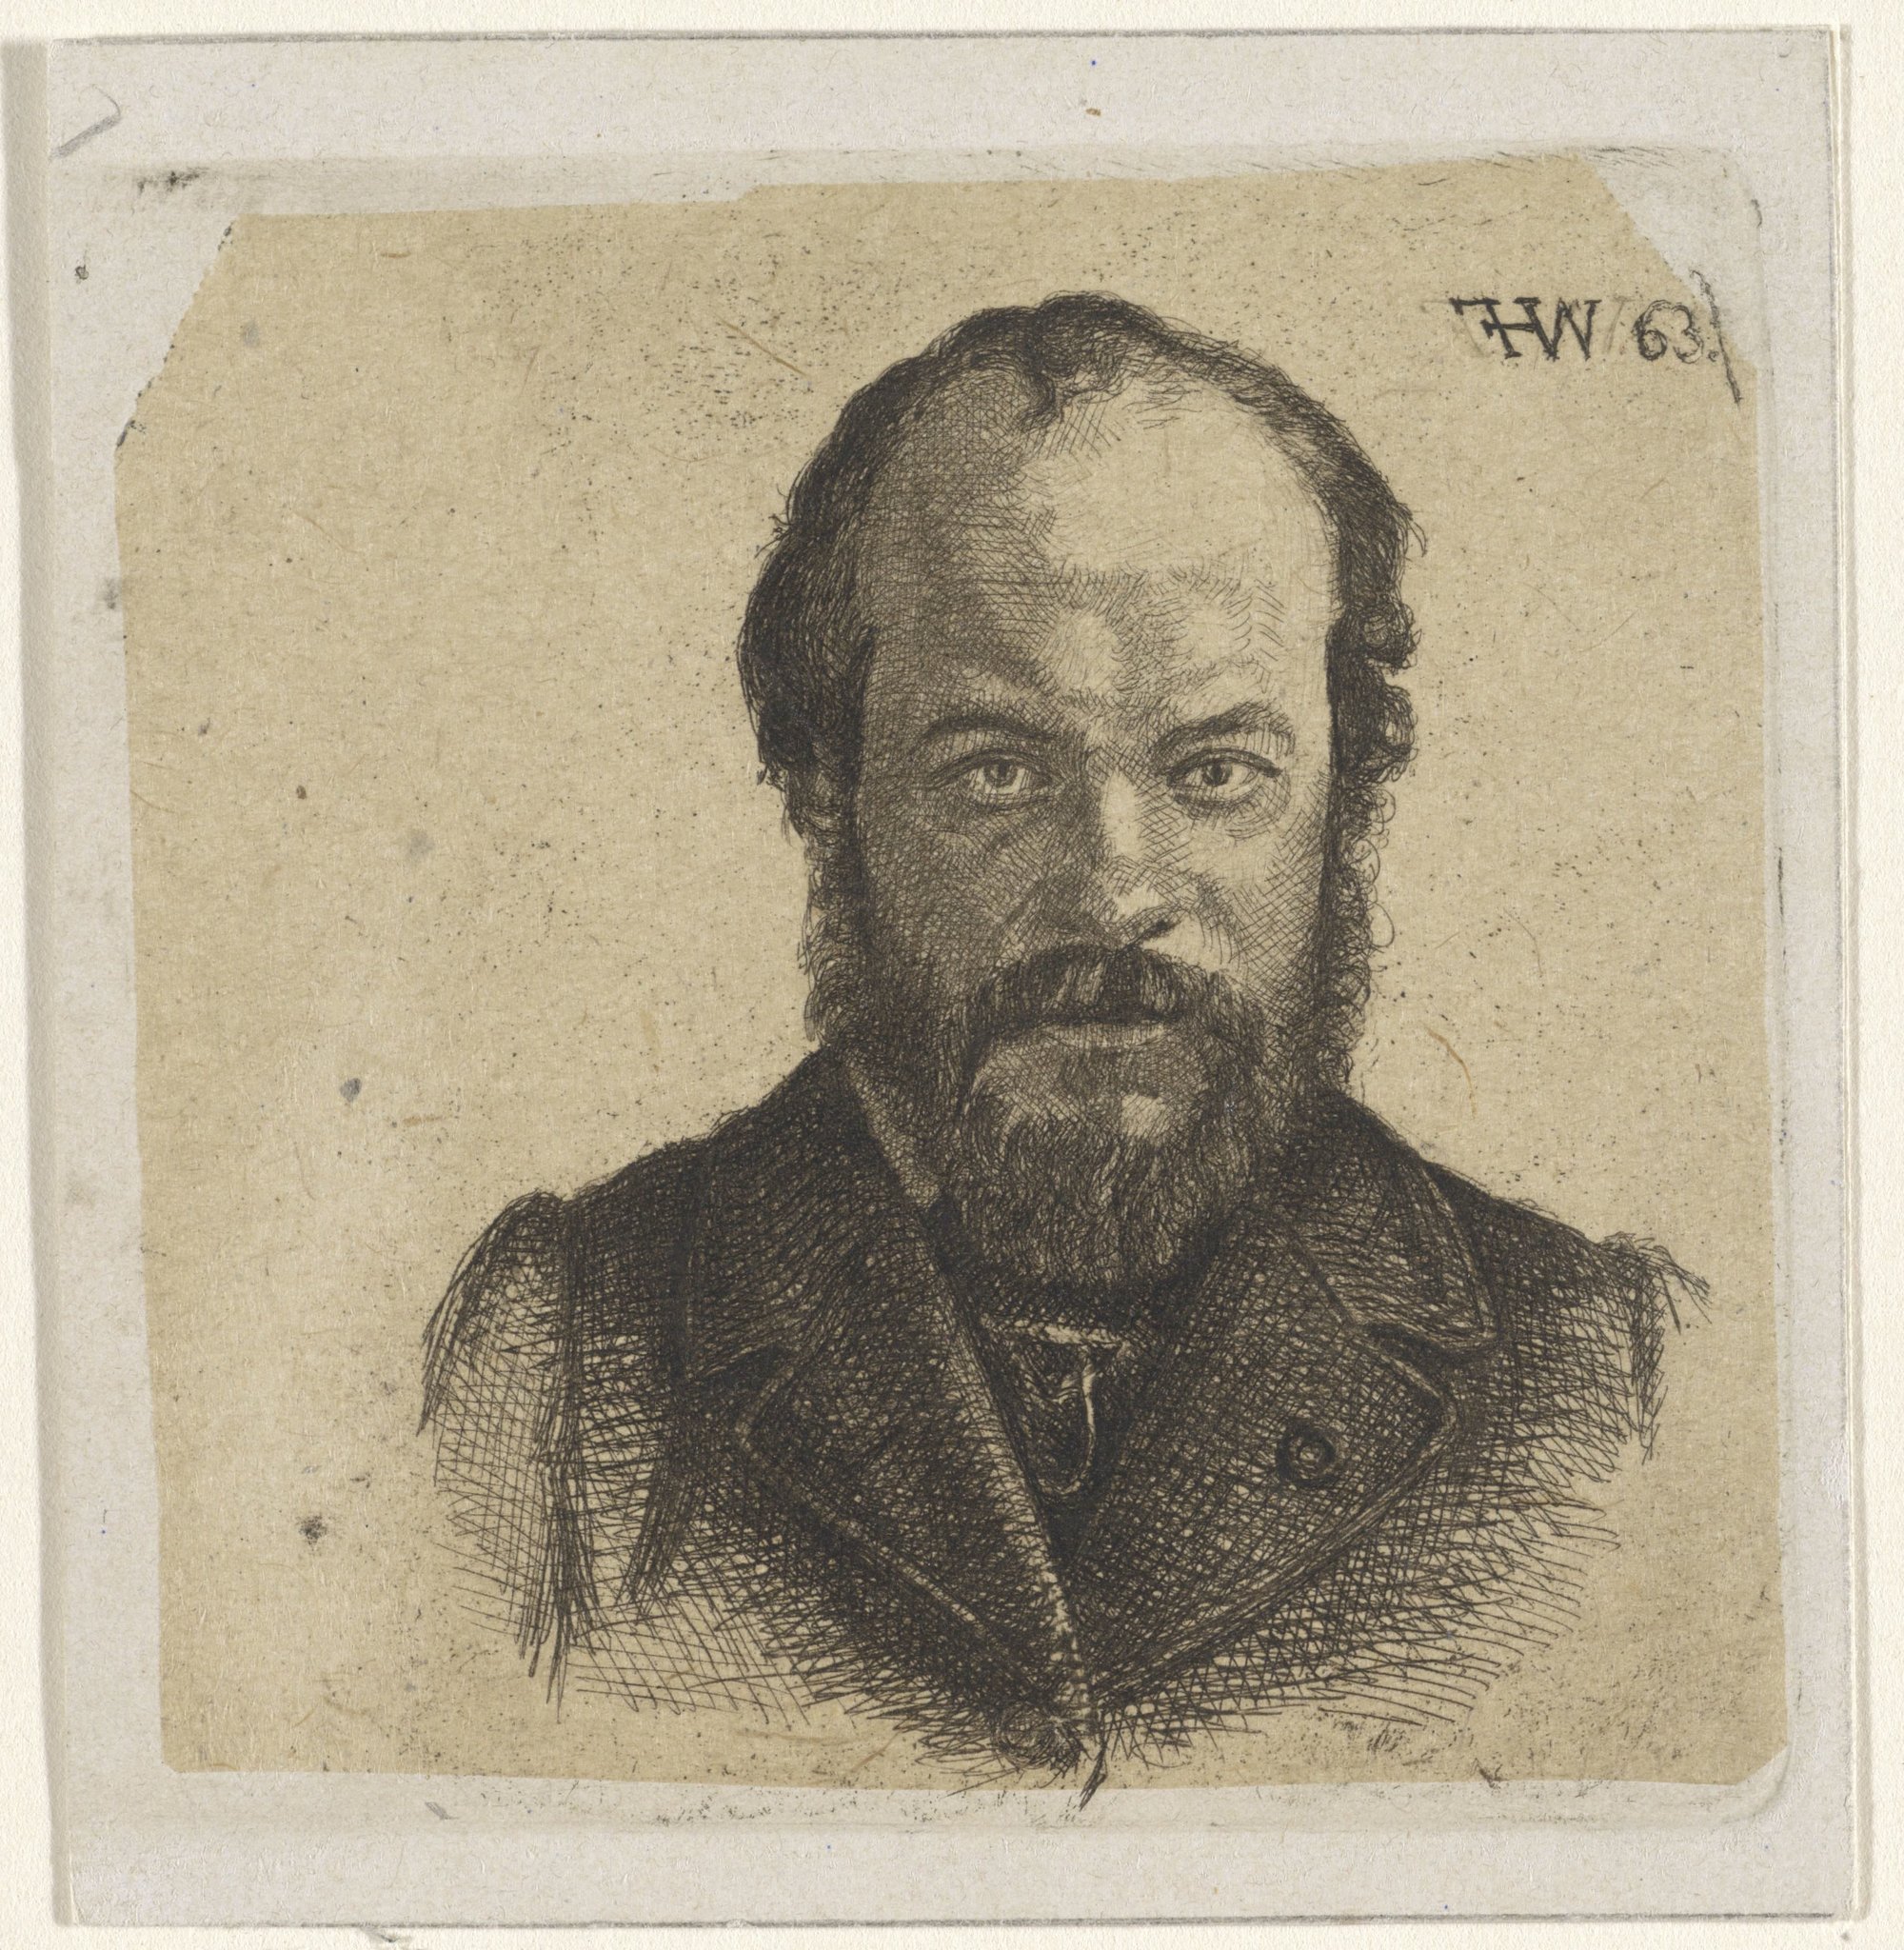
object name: print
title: Portret van Jan Weissenbruch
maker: frederik hendrik weissenbruch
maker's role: draughtsman, print maker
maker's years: 1828-1887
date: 1863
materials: paper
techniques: etching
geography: the hague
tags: the hague, painter, print maker, jan weissenbruch, historical persons, portrait, self-portrait of artist, beard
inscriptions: collector's mark: Lugt 2228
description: Portret van de kunstenaar Jan Weissenbruch, oudere broer en leermeester van de vervaardigend kunstenaar.